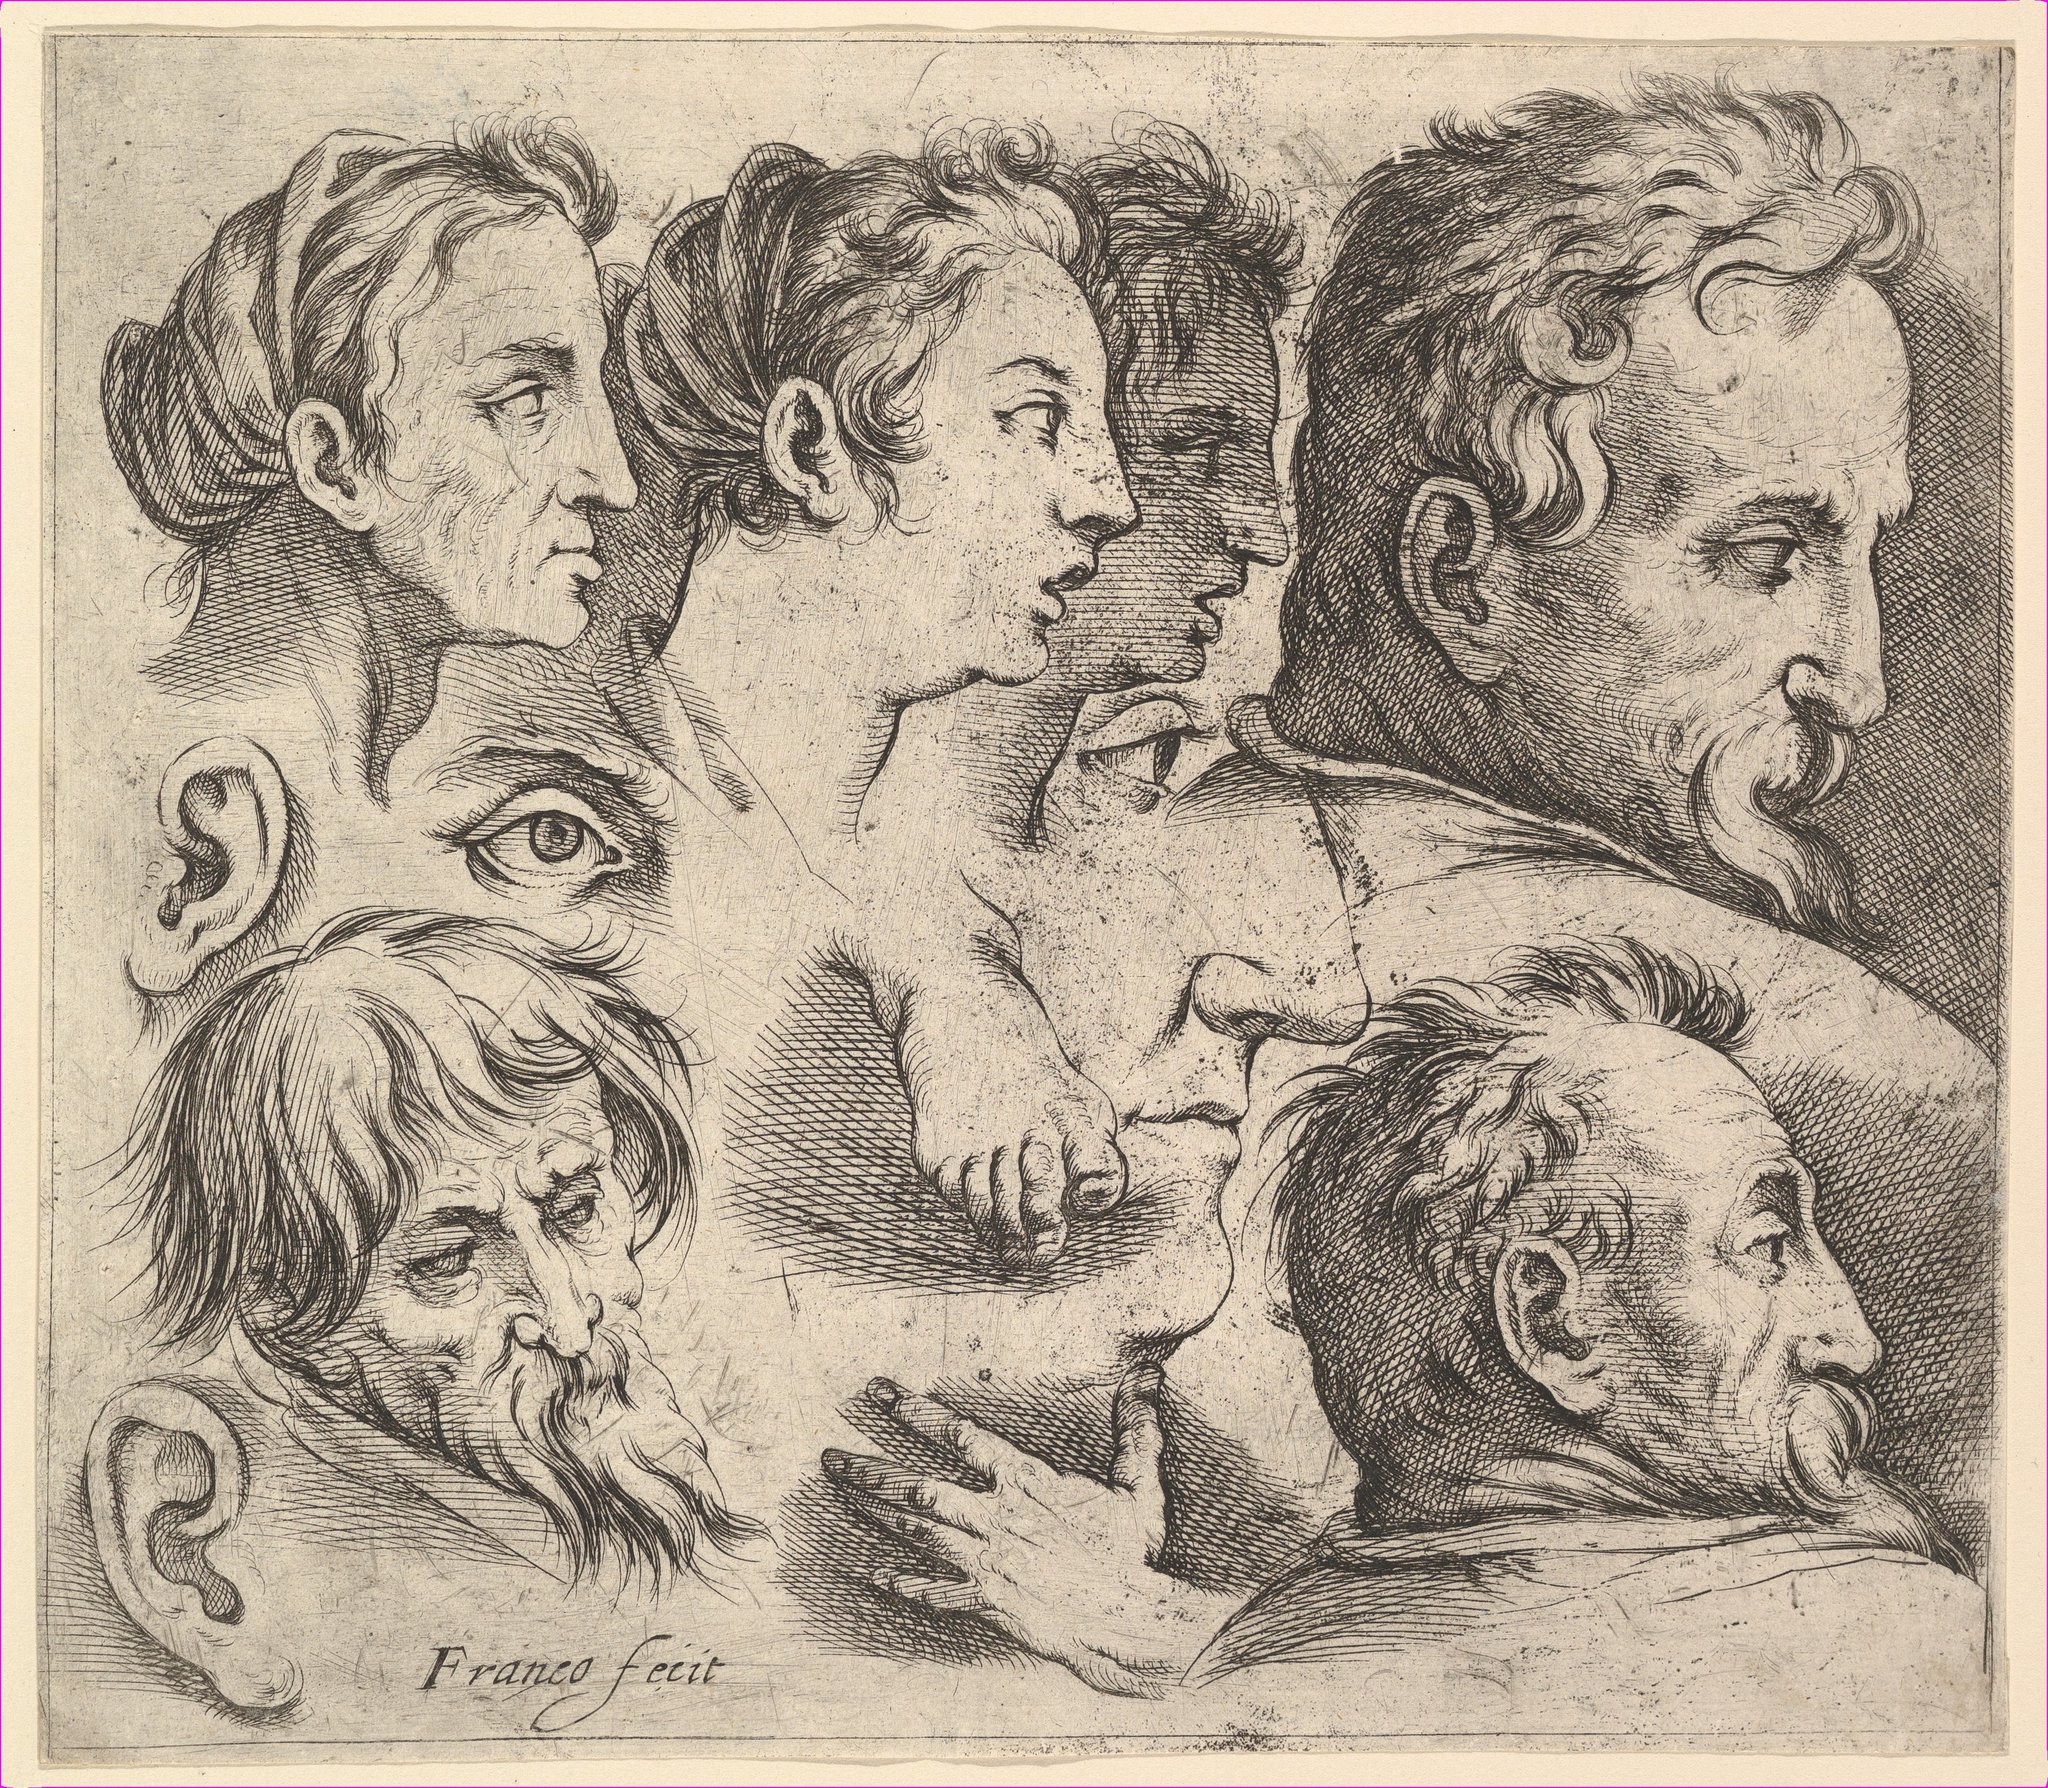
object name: print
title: Studies of Heads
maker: battista franco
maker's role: artist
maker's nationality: italian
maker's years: 1510-1561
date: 1501-1600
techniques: engraving, etching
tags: feet,hands,heads,men,women